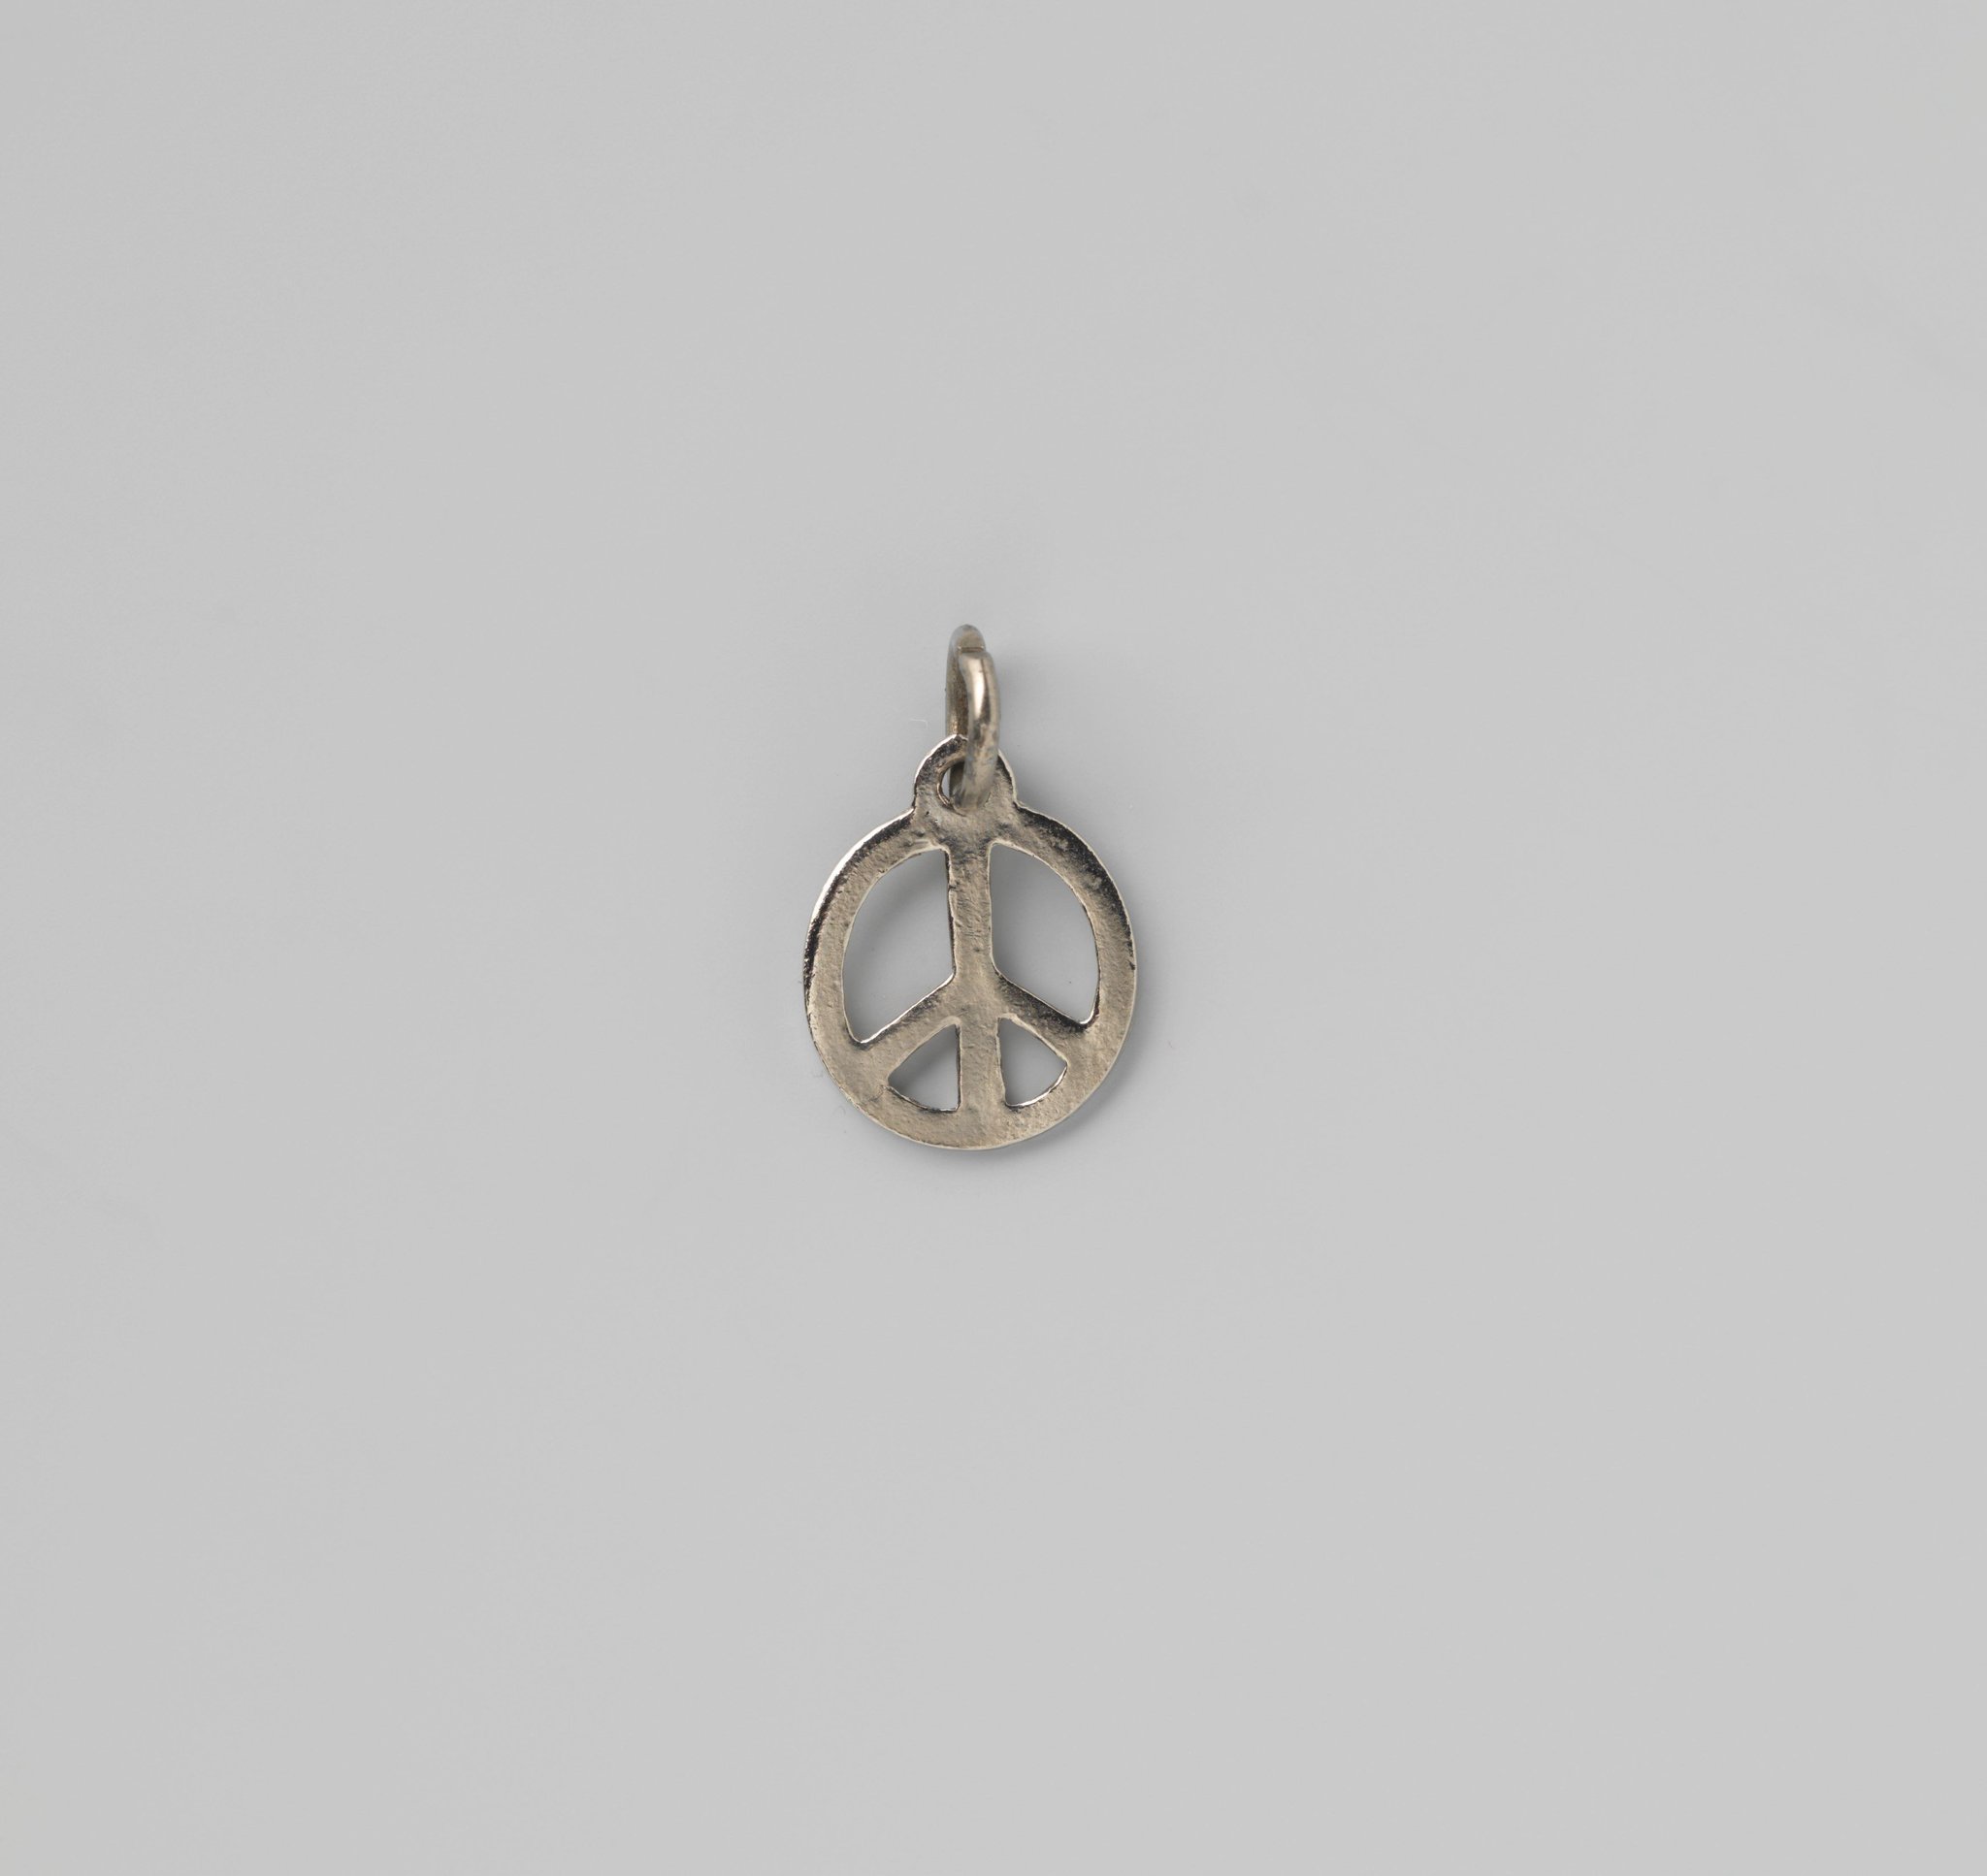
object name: pendant jewelry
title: Hanger 'Ban de bom' van onedel metaal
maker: Anonymous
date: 1980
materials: metal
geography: europe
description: Hanger 'Ban de bom' van onedel metaal met draadoog.